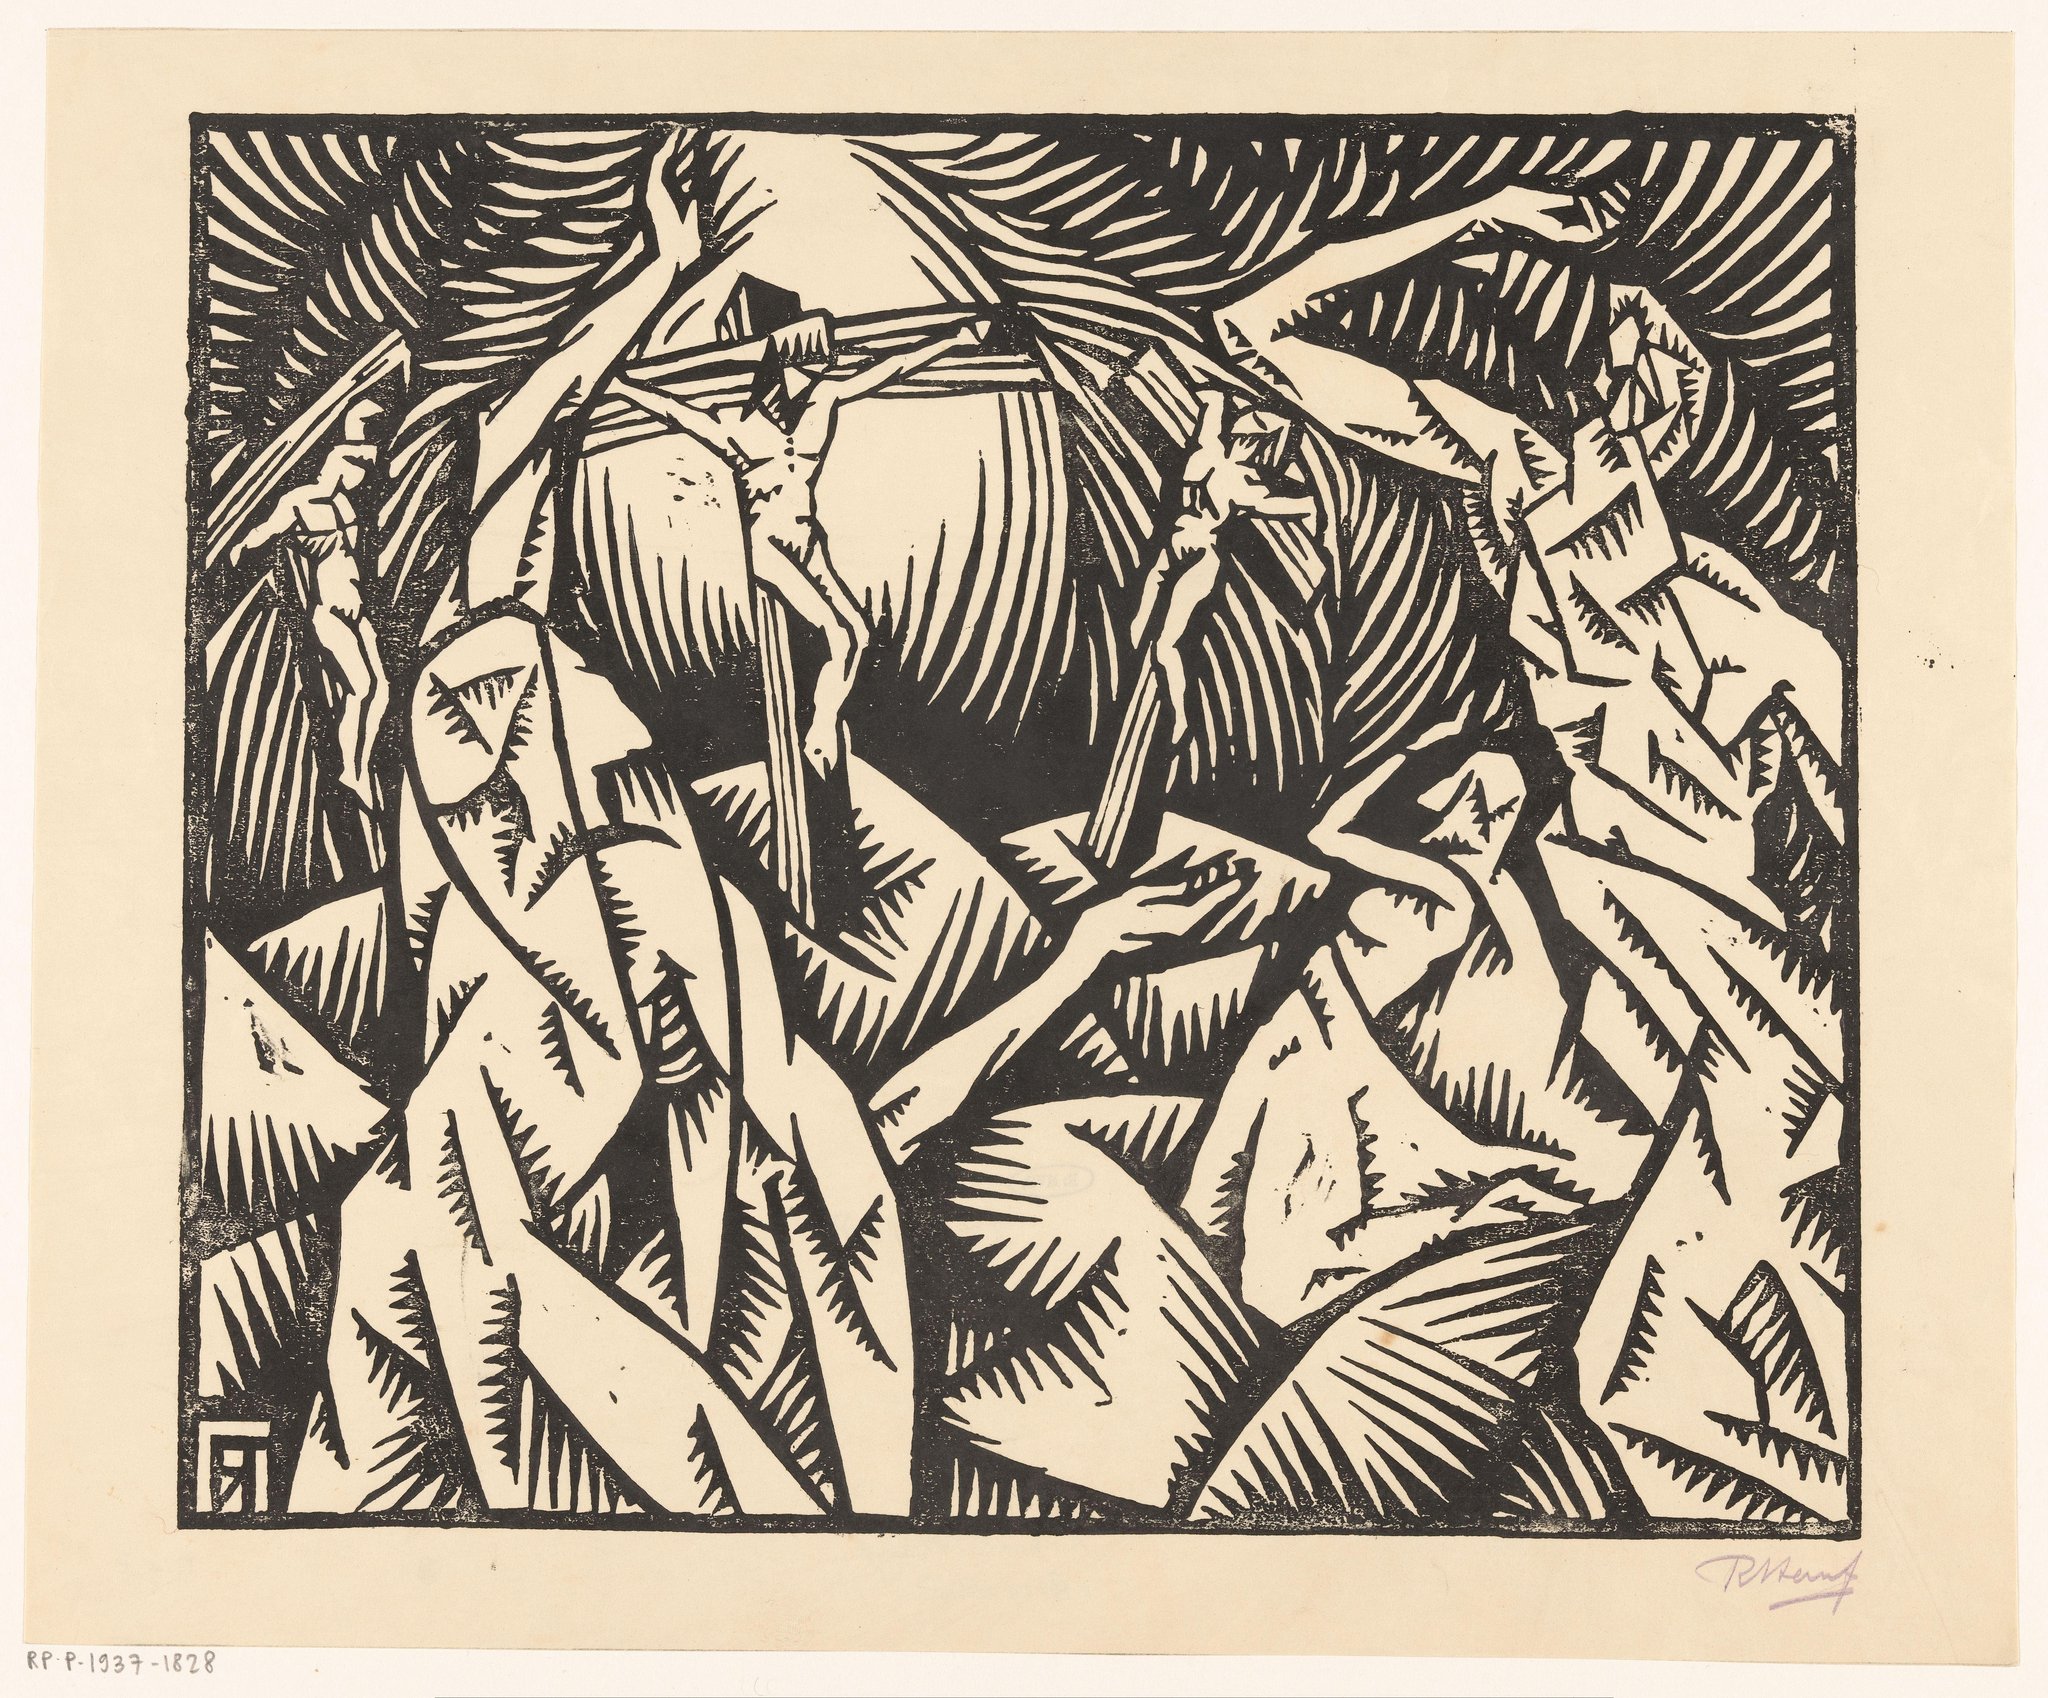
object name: print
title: Golgotha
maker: bob hanf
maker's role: draughtsman, print maker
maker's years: 1894-1944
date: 1904-1937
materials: paper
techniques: woodcut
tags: the crucifixion of christ: christ's death on the cross; golgotha (matthew 27:45-58; mark 15:33-45; luke 23:44-52; john 19:25-38)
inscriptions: collector's mark: Lugt 2760, collector's mark: Lugt 2228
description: De heuvel Golgota met Christus en de twee misdadigers aan het kruis. Voor hen twee Maria's en een bebaarde man.